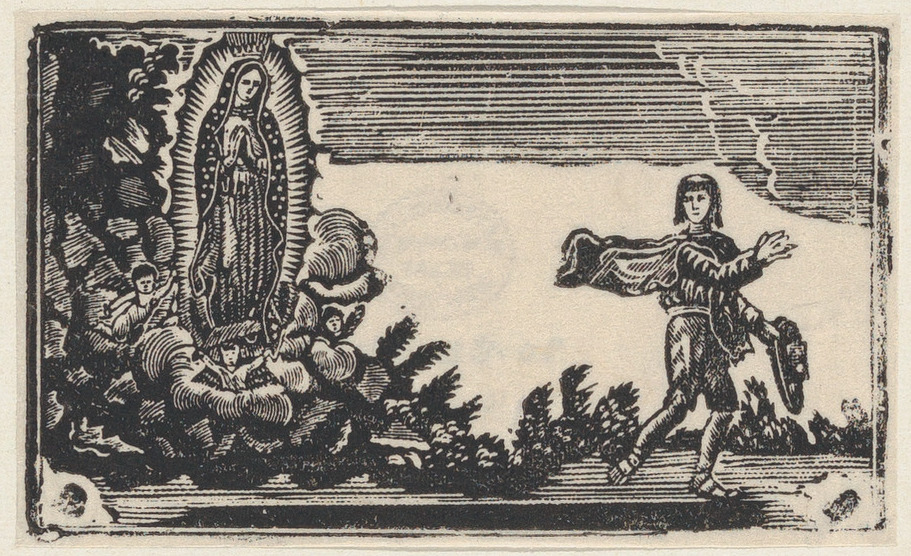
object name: print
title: The Virgin of Guadalupe appearing to a man holding a hat (possibly Juan Diego)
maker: anonymous, mexican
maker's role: artist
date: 1801-1900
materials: metal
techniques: engraving